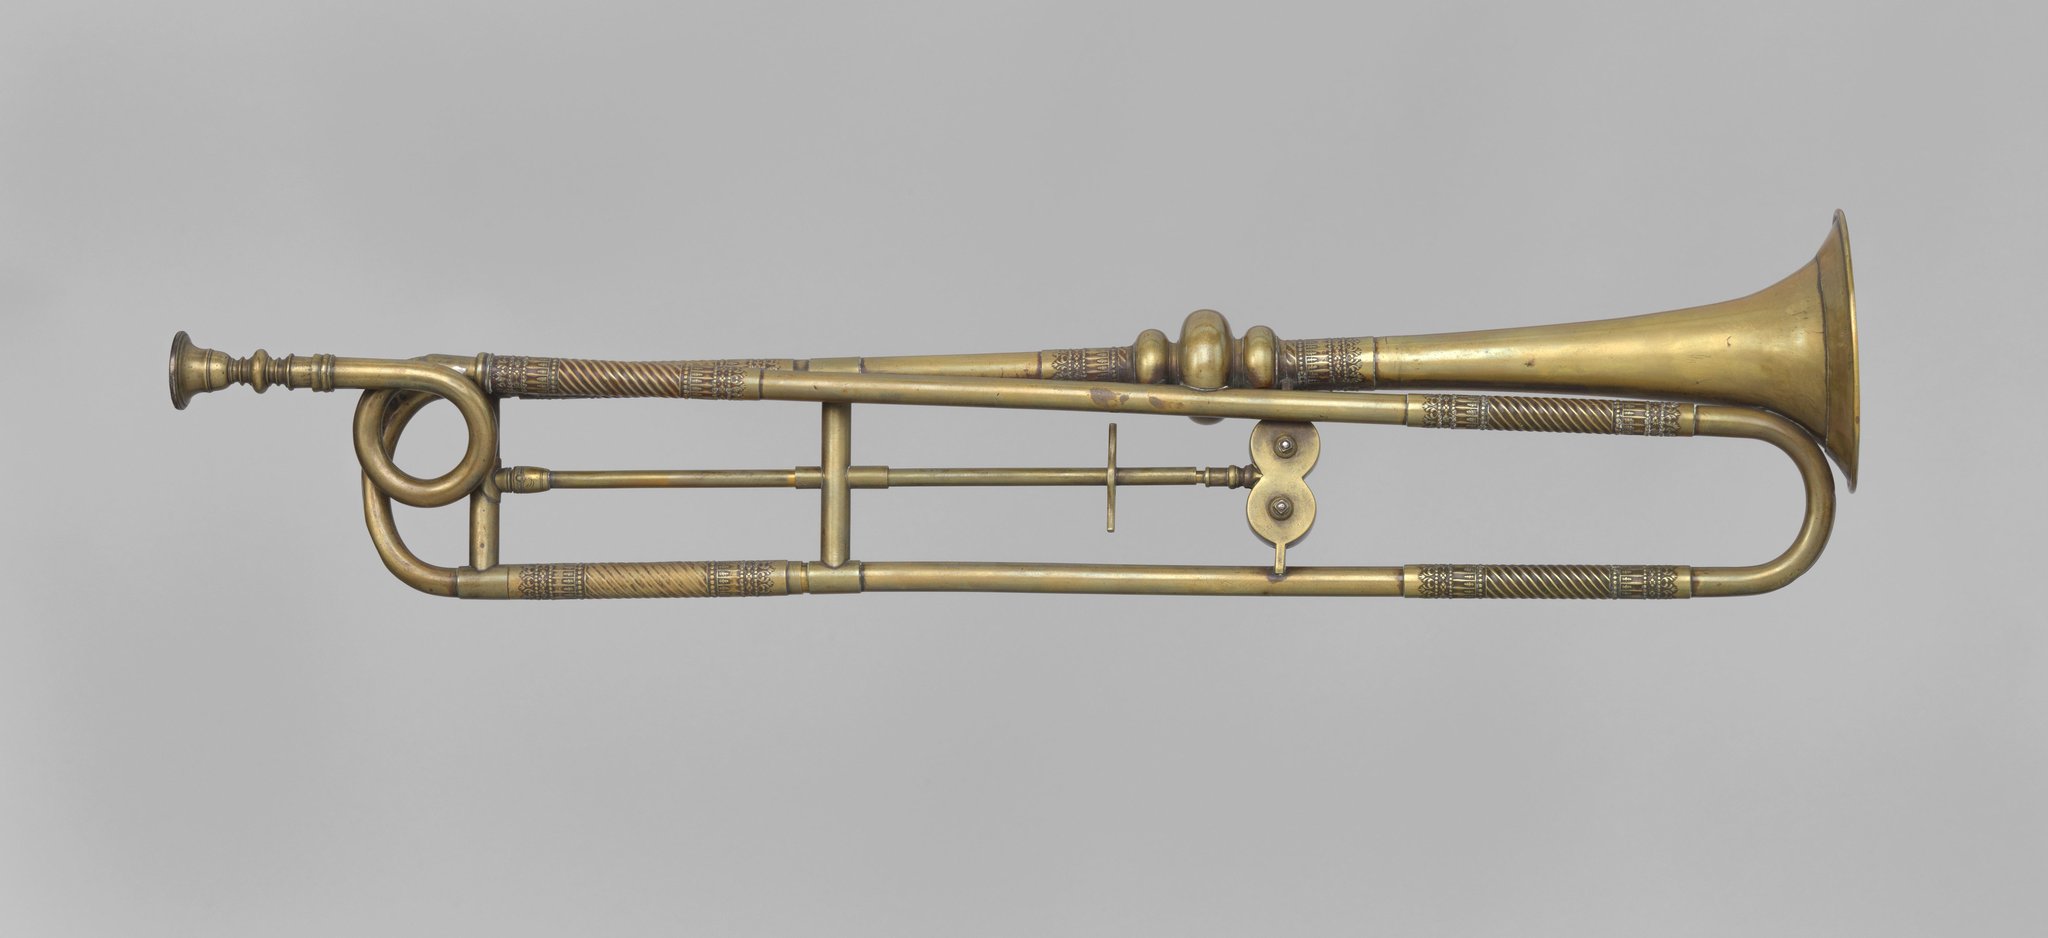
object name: trumpet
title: Slide trumpet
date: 1810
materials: brass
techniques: hammering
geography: london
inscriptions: name: ‘Goulding & Co / 20 Soho Squ.re / London’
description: Schuiftrompet De buislassen zijn gedecoreerd met spiraalvormige motieven met bladeren. De naam van de maker is gegraveerd aan de buitenzijde van de beker: Goulding & Co / 20 Soho Squ.re / London.